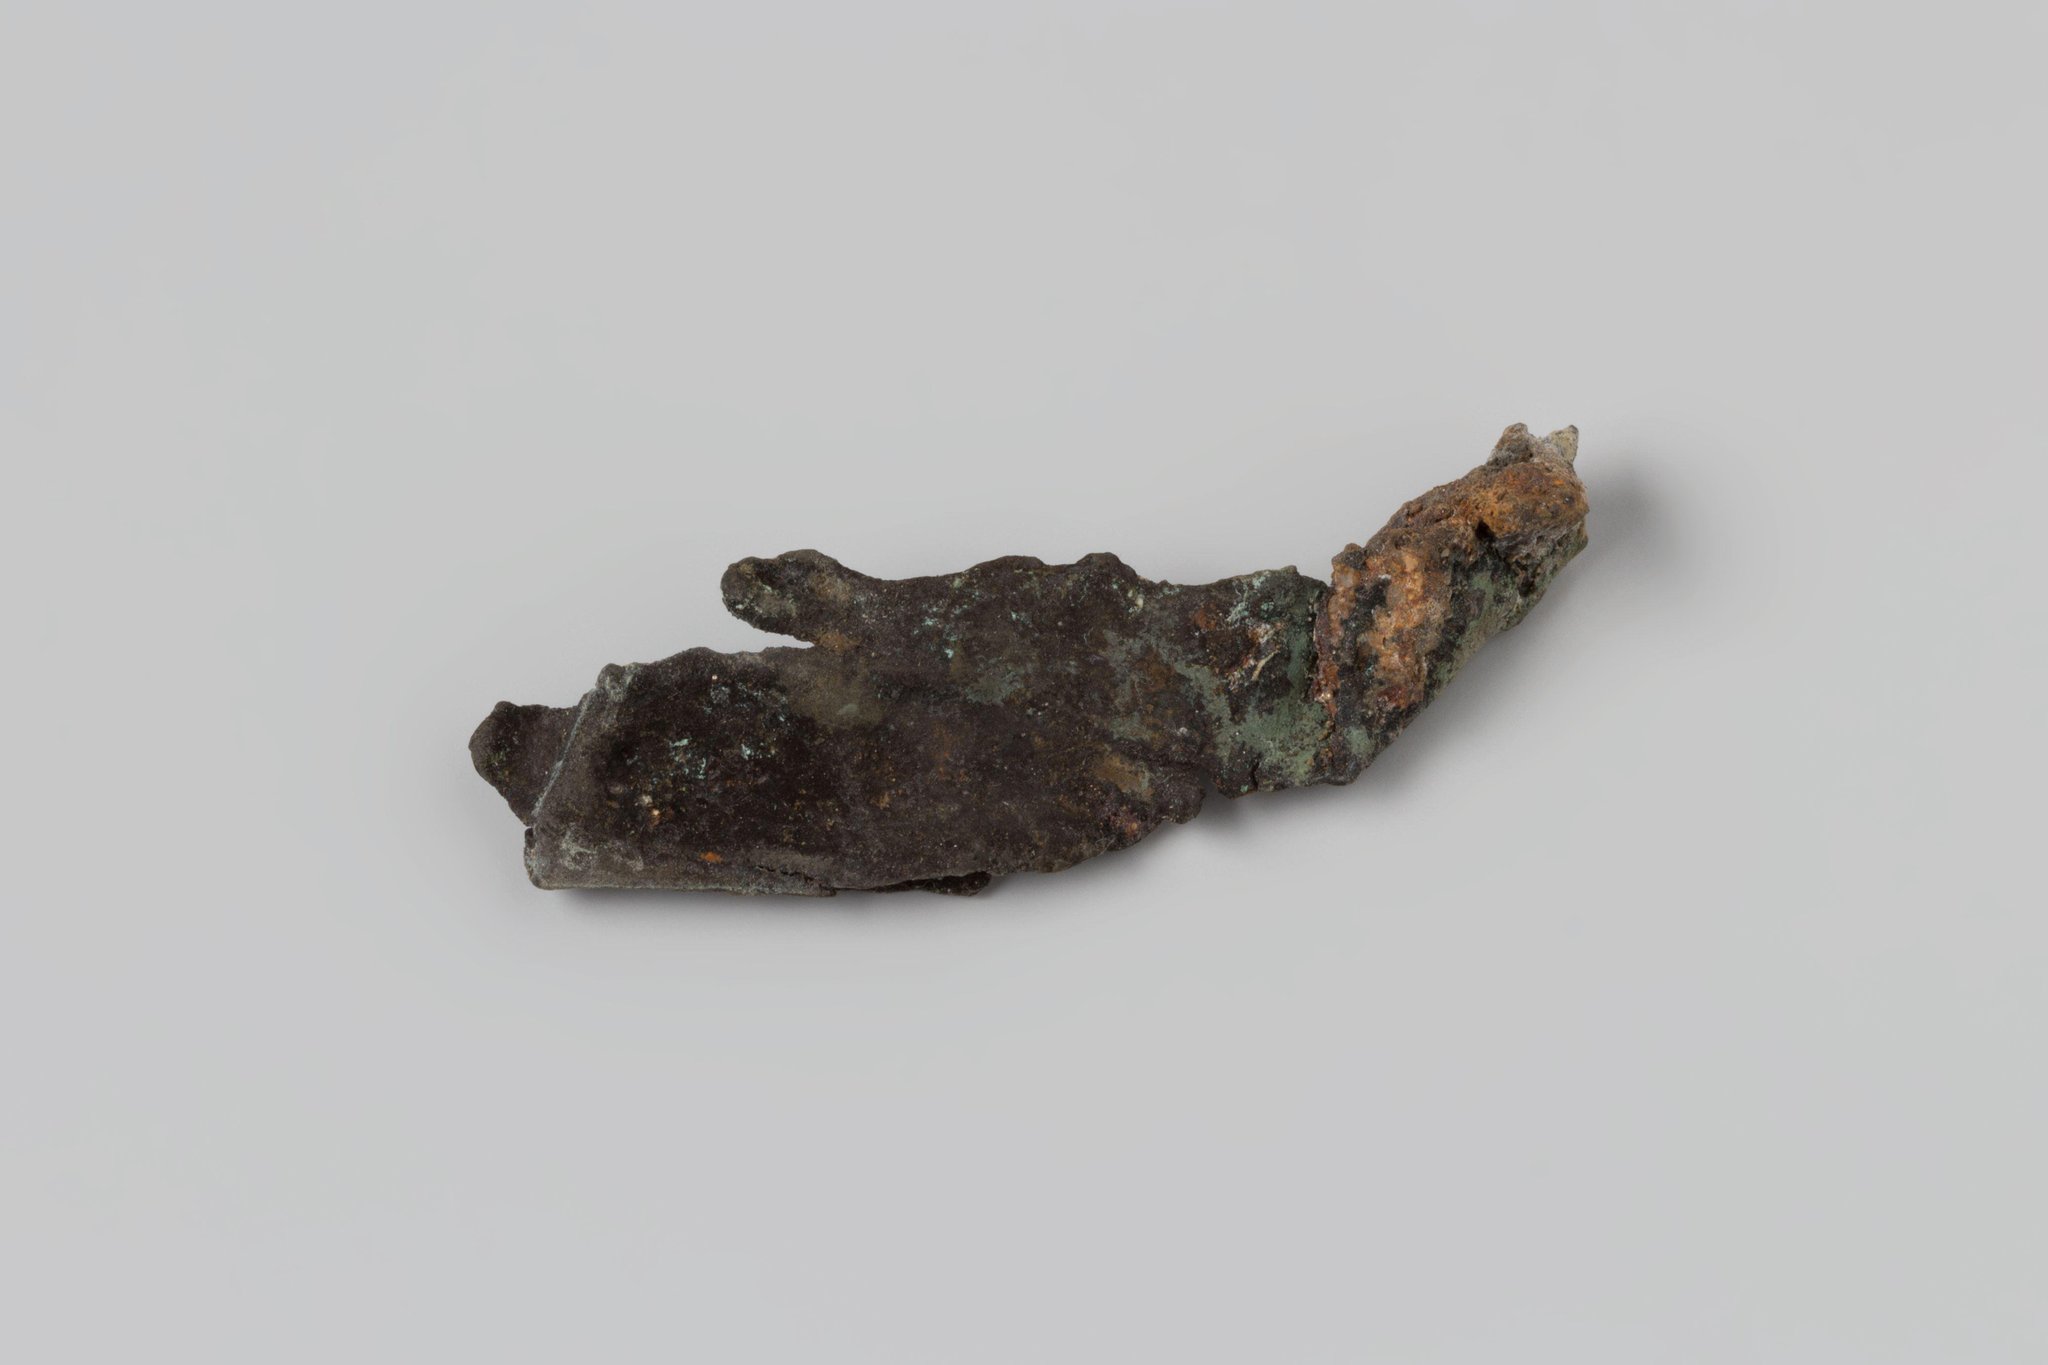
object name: scheepswrakvondst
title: Fragment van koper uit het wrak van de Oost-Indiëvaarder Hollandia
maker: Anonymous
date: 1700-1743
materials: copper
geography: netherlands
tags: verenigde oostindische compagnie, hollandia (schip), annet